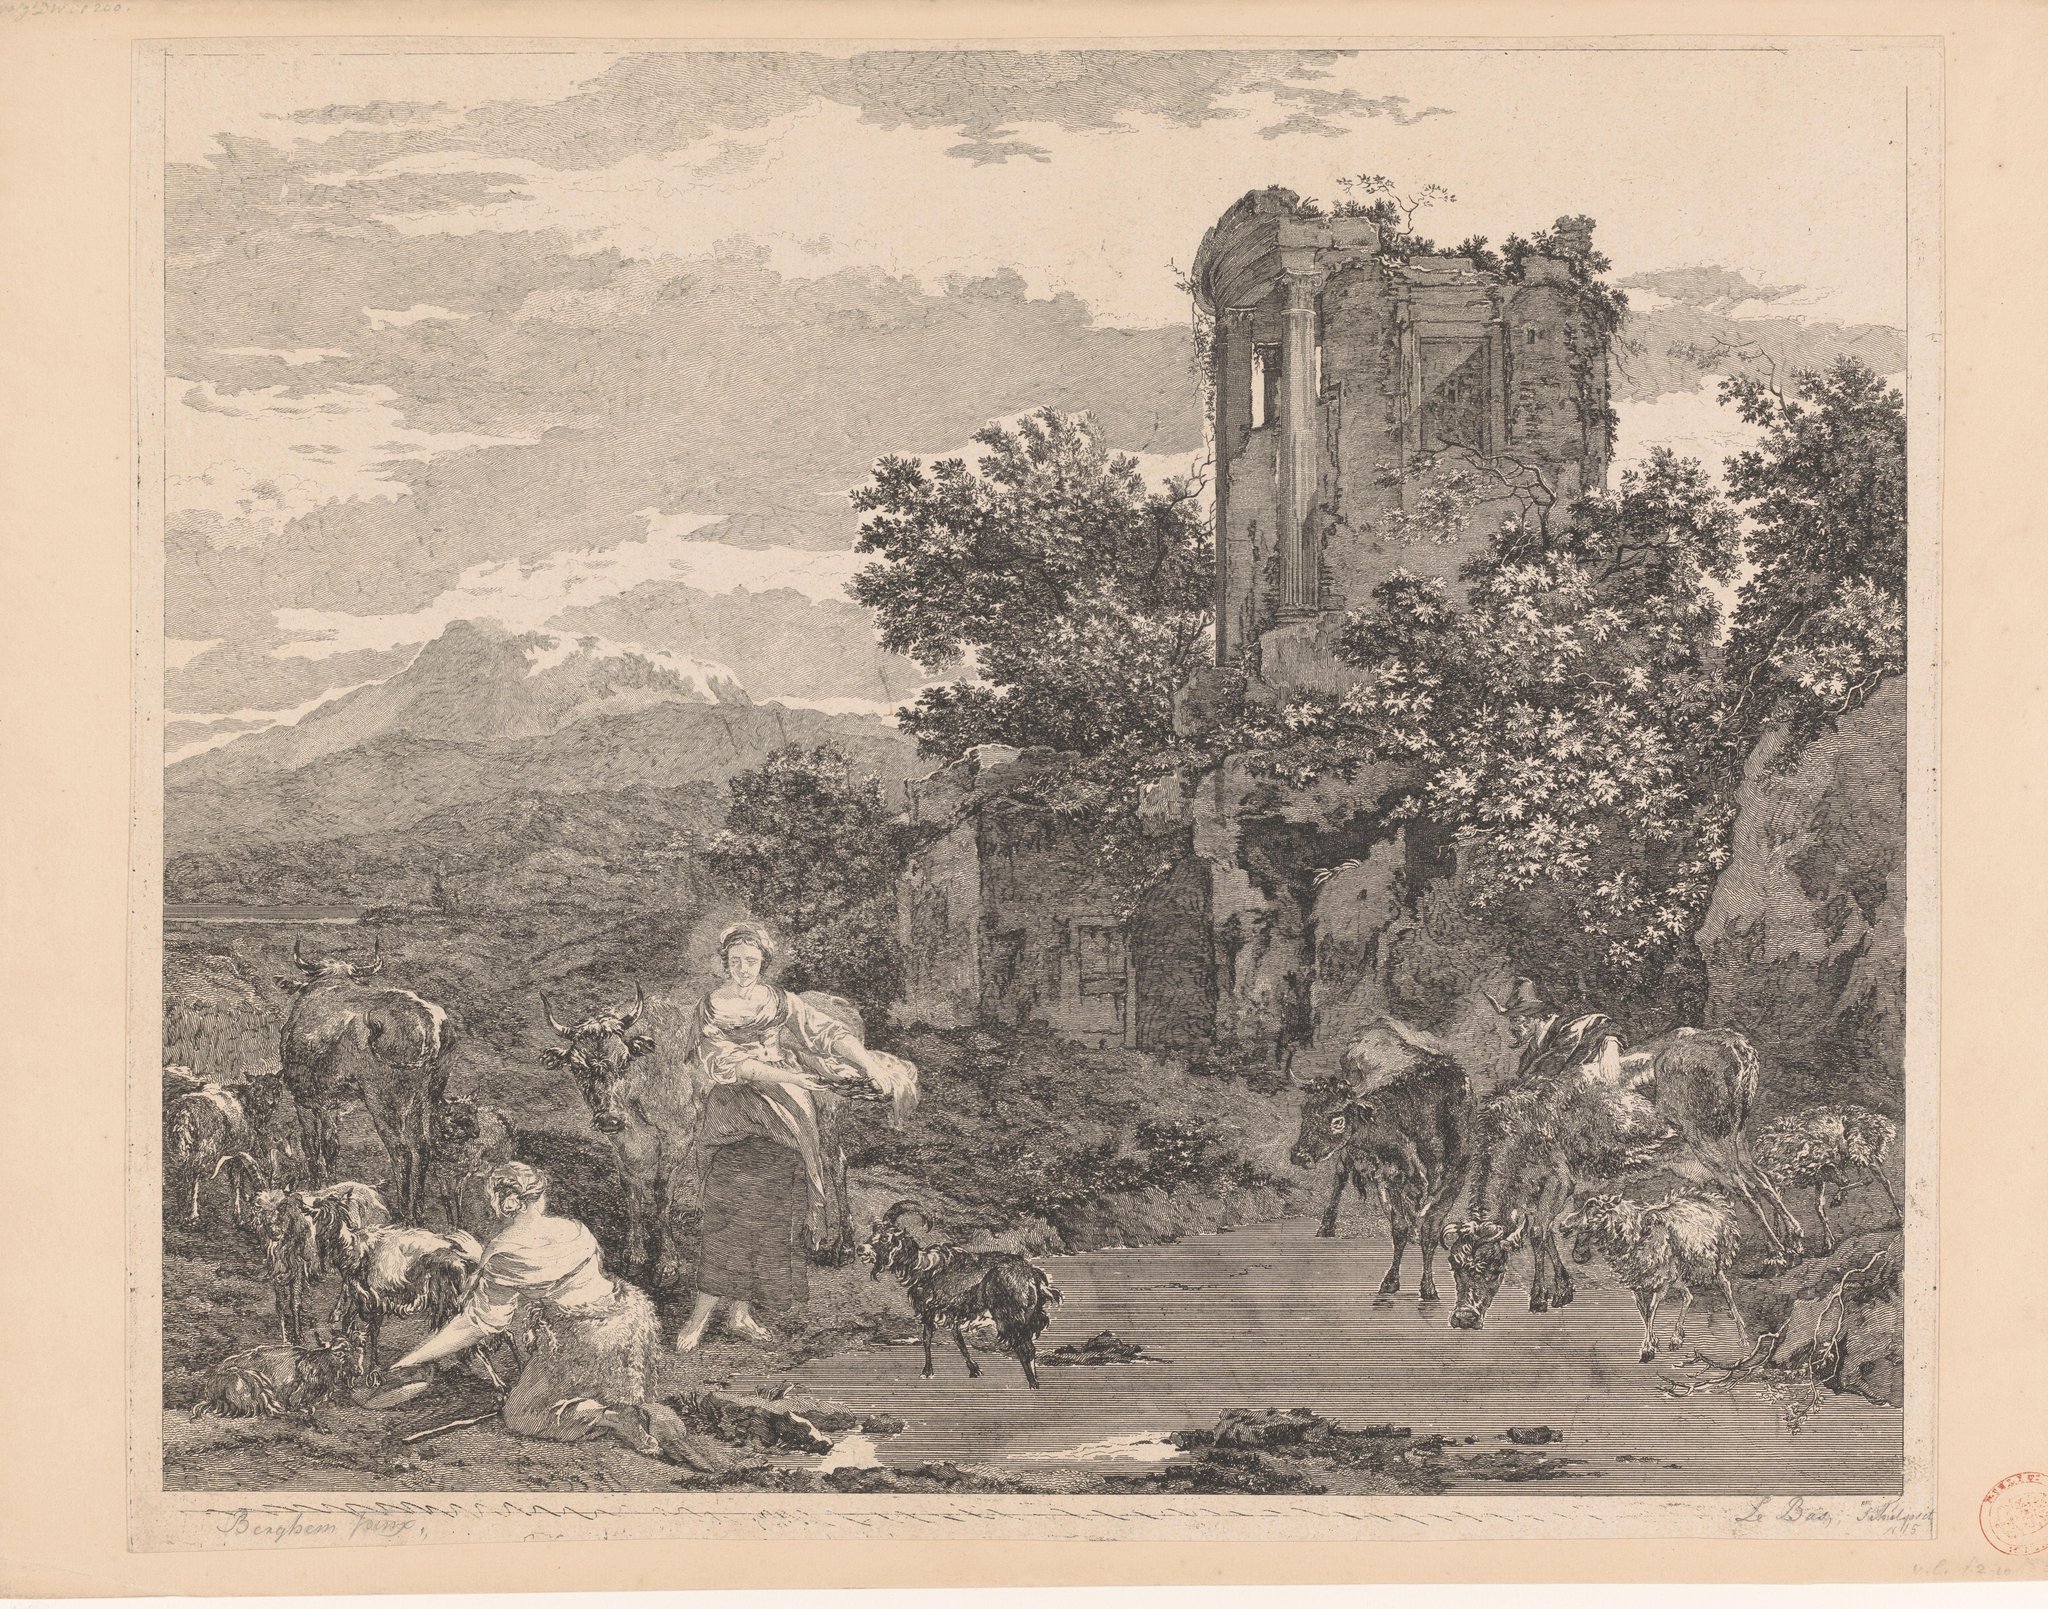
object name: print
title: Landschap met twee herderinnen en drinkend vee bij een ruïne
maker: pierre jacques duret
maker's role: print maker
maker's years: 1729-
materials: paper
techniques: etching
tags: landscape with ruins, herd, flock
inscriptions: collector's mark: Lugt 240